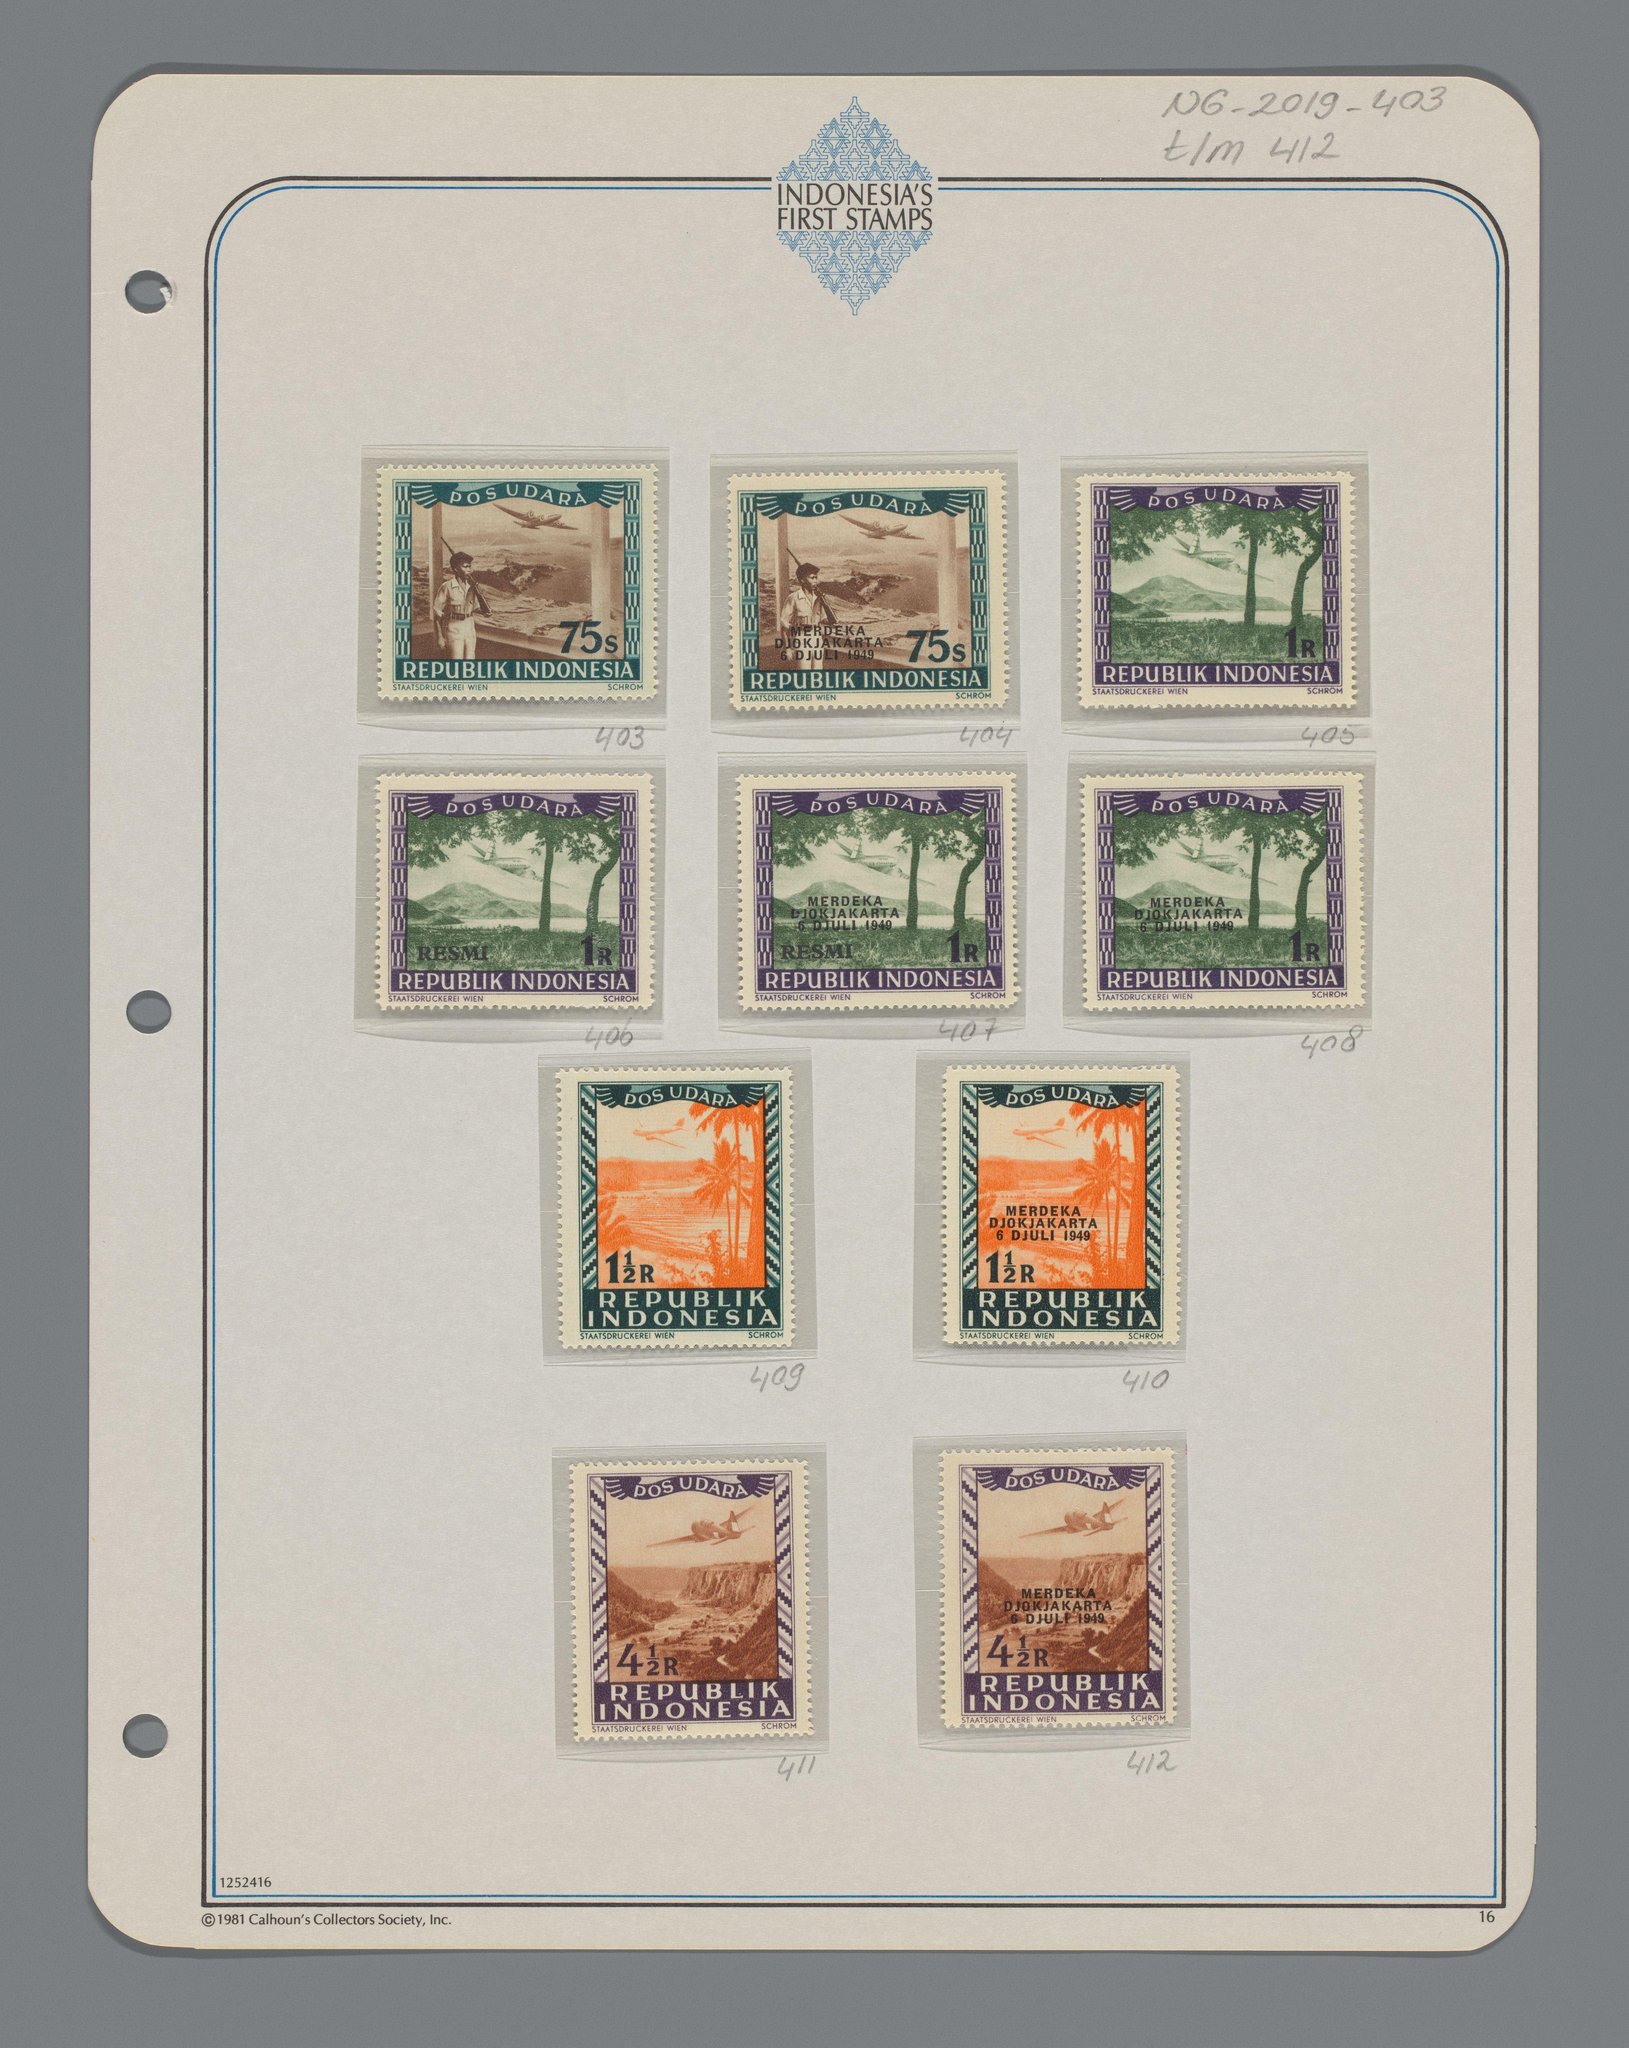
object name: postage stamp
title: Postzegel Republik Indonesia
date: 1949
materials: paper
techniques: photoaquatint, engraving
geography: vienna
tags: indonesia